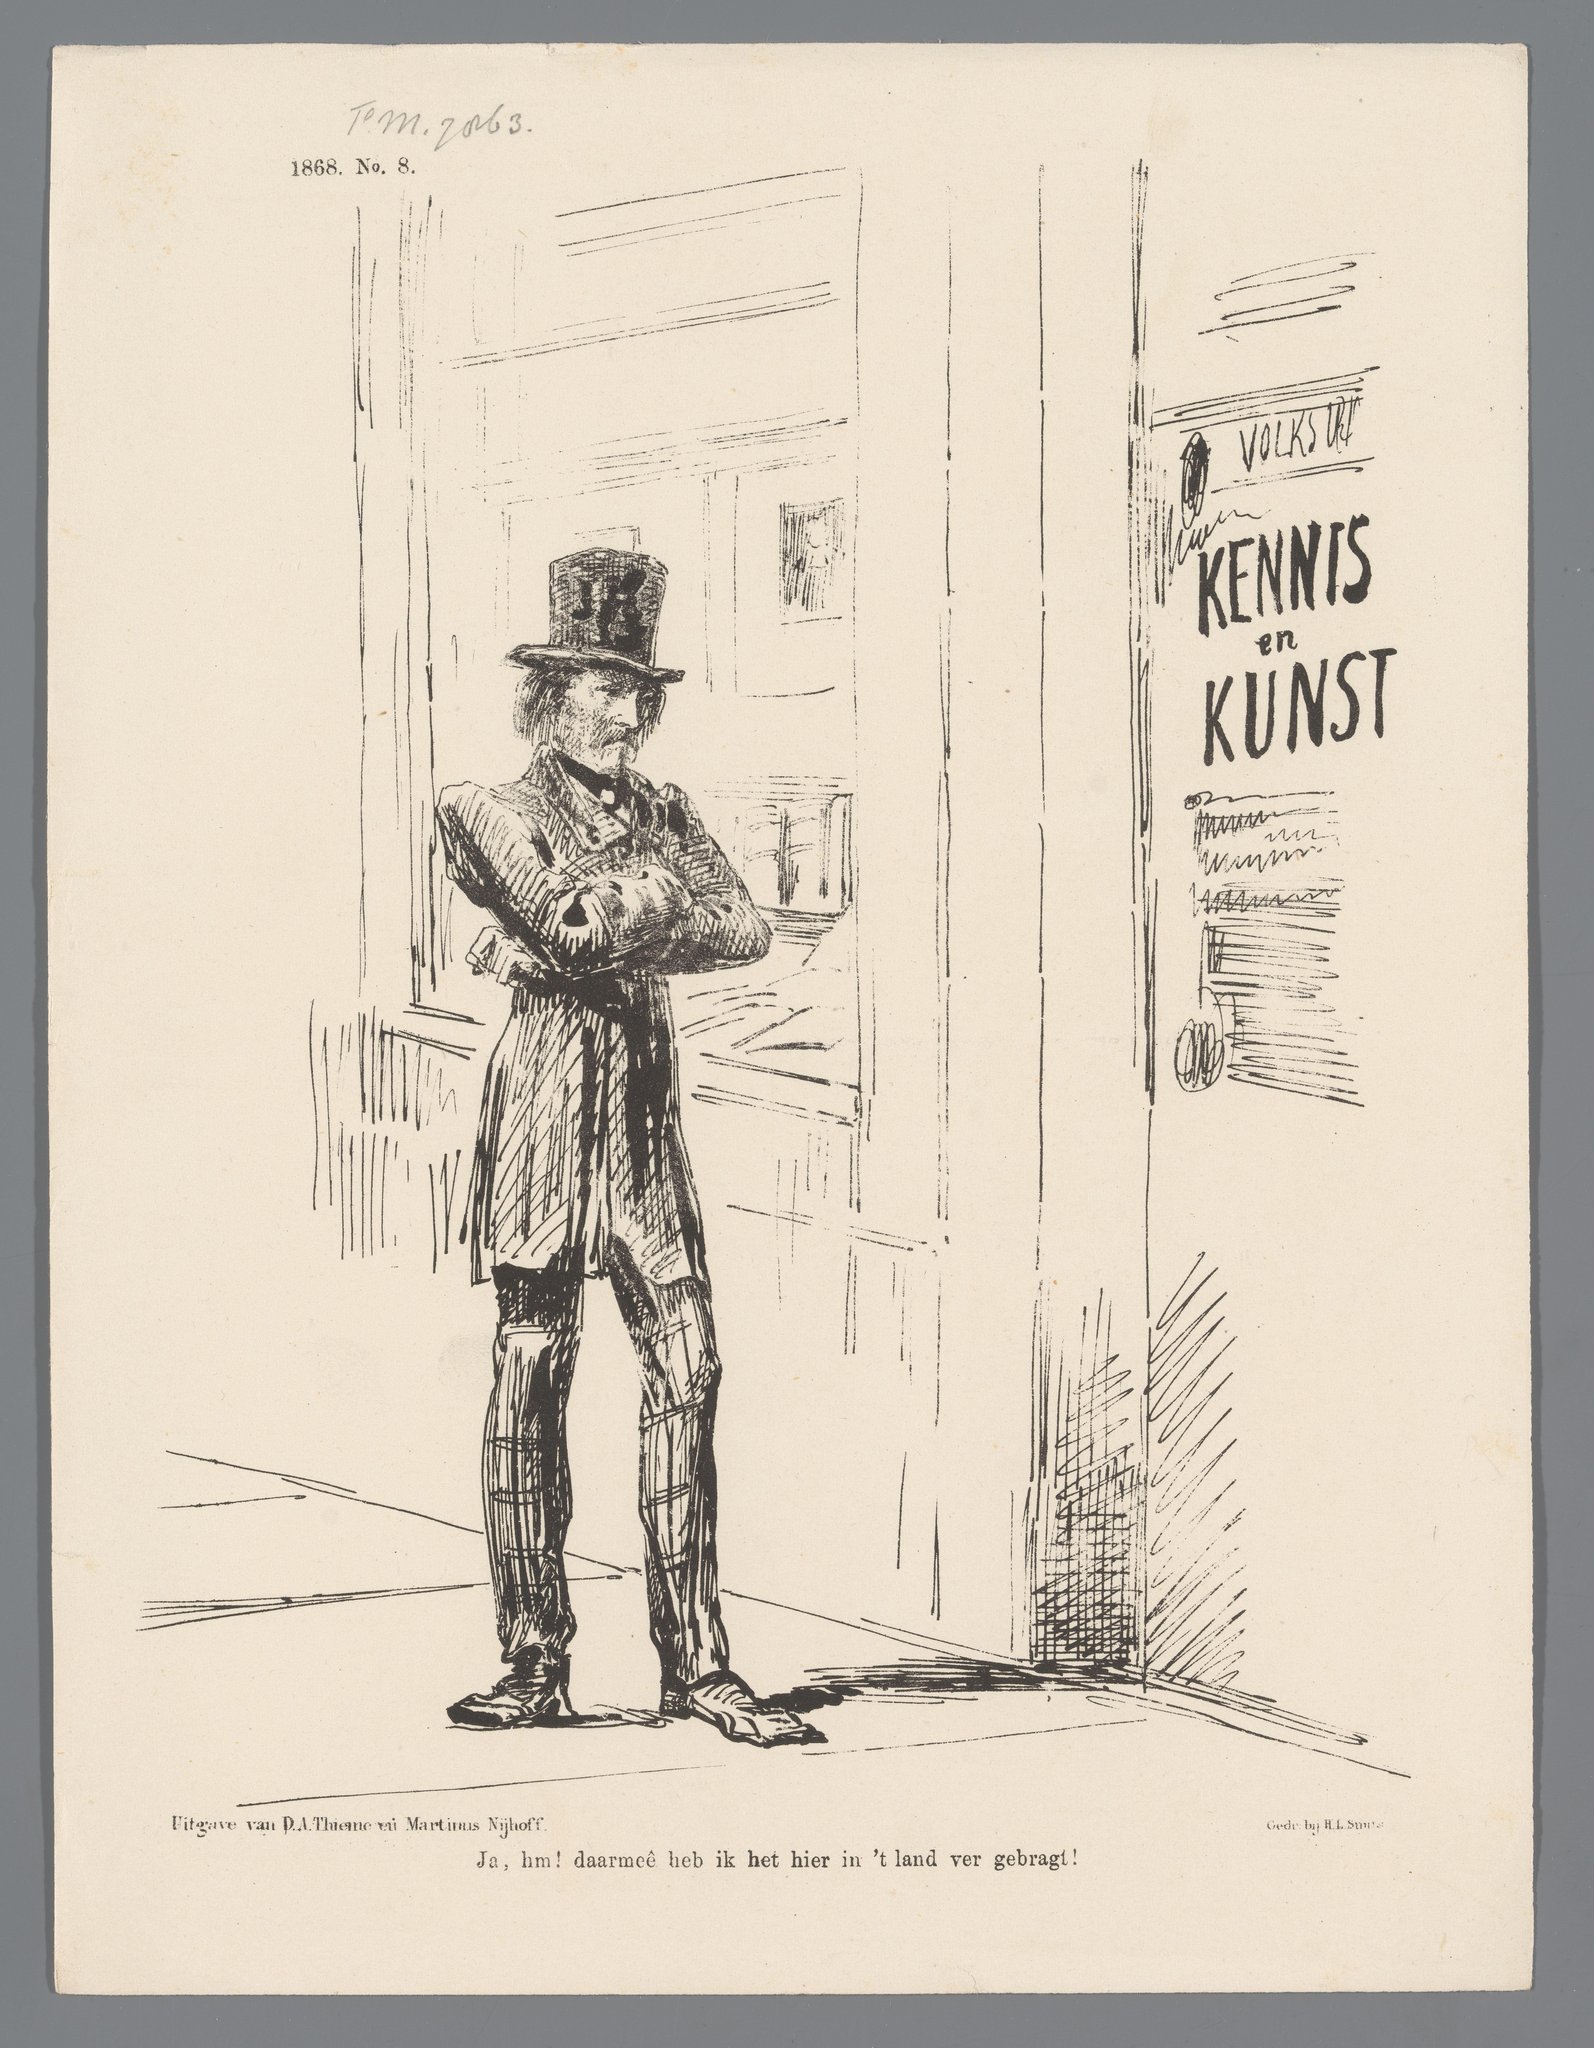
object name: print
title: Spotprent op het gebrek aan kunstzin in Nederland, 1868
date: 1867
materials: paper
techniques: lithograph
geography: netherlands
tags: artist in non-work situation, the poor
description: Spotprent op het gebrek aan kunstzin in Nederland. Een haveloze kunstenaar staande voor het aanplakbiljet 'Kennis en Kunst'. Plaat verschenen bij het weekblad De Nederlandsche Spectator, nr. 8, 22 februari 1868.